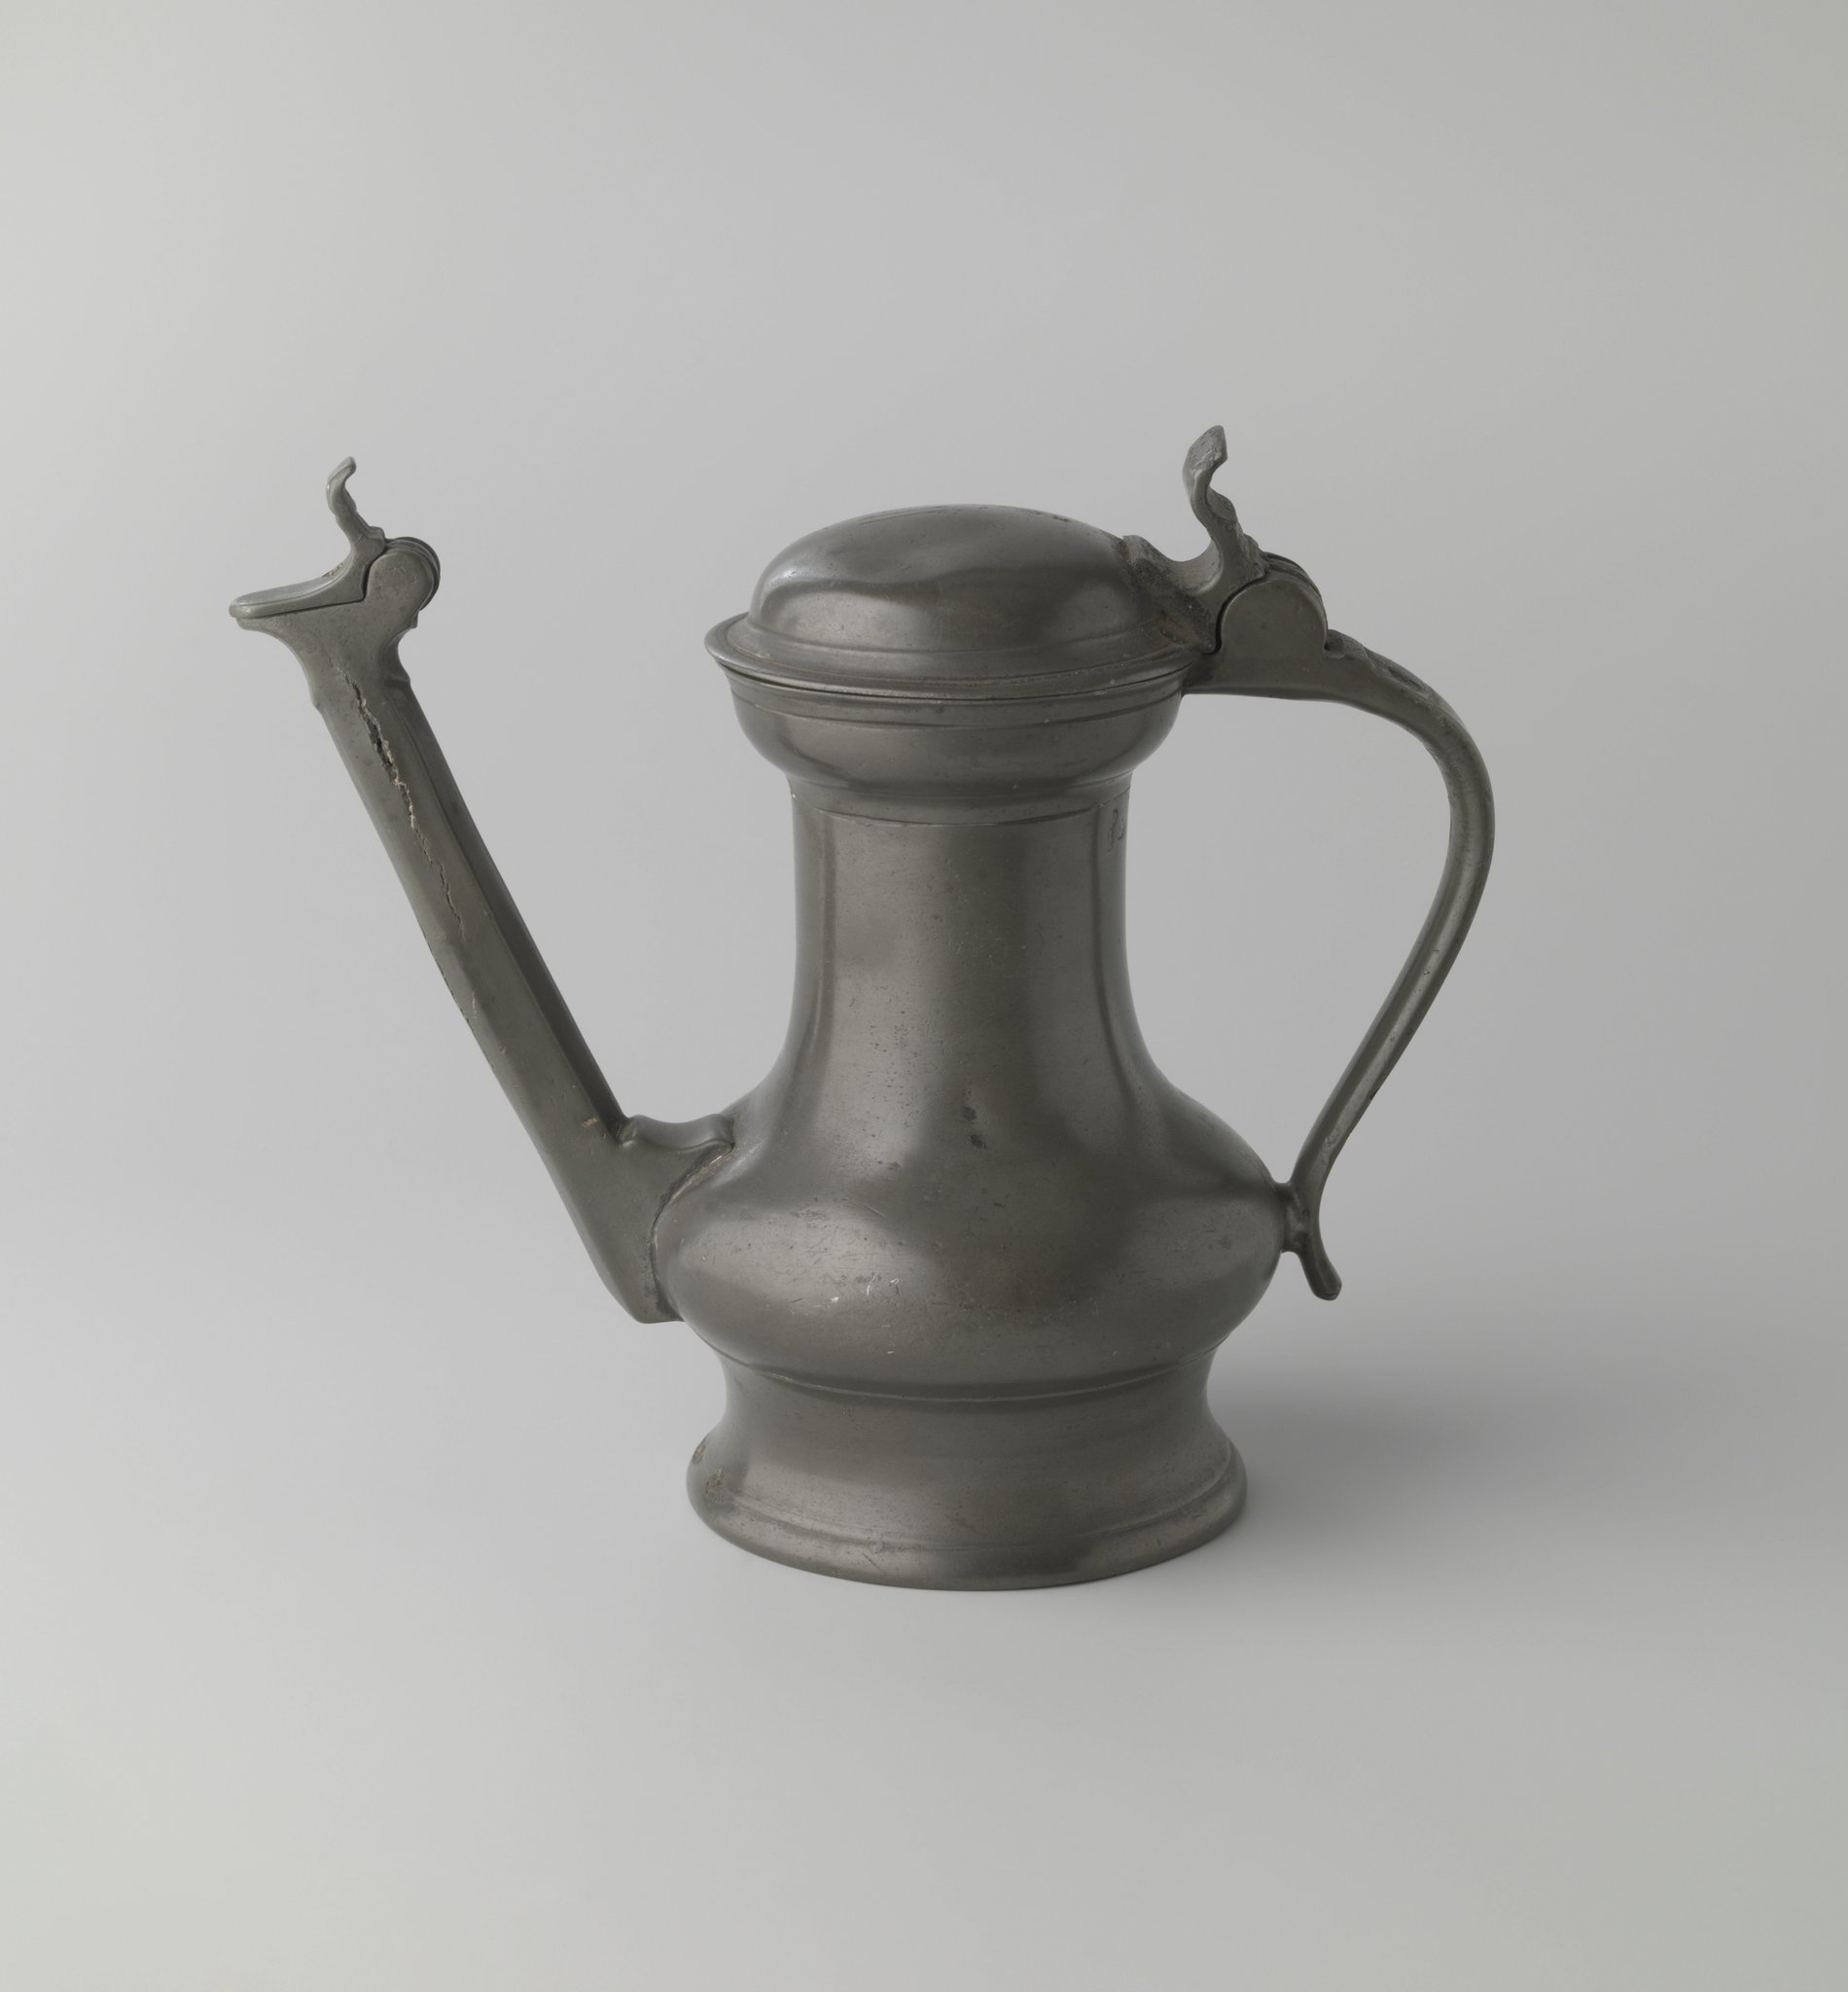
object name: tuitkan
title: Tuitkan van tin met deksel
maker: Anonymous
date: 1600-1650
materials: tin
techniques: casting, turning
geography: amsterdam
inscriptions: quality mark, inscription, quality mark, quality mark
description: Tuitkan van tin. De standring gaat over in een brede, platte buik, die overloopt in een cylindervormige hals. Bovenaan is een brede liprand, die naar buiten uitloopt. De kan wordt afgesloten met een gewelfd deksel. Het geprofileerd duimrust loopt via een dubbelkakig scharnier over in het handvat, dat onderaan op het breedste punt van de buik vastzit en daarna iets naar buiten uitloopt. De rechte tuit loopt vanaf het breedste punt van de buik schuin naar boven en wordt afgesloten met een klein klepje met een geprofileerd duimrust.